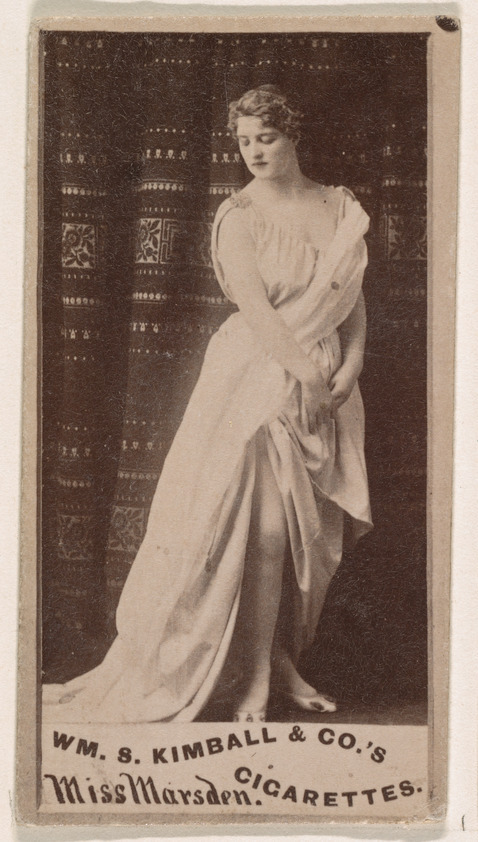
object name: photograph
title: Miss Marsden, from the Actresses series (N203) issued by Wm. S. Kimball & Co.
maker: william s. kimball & company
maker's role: publisher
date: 1889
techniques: color lithograph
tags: portraits,women,actresses